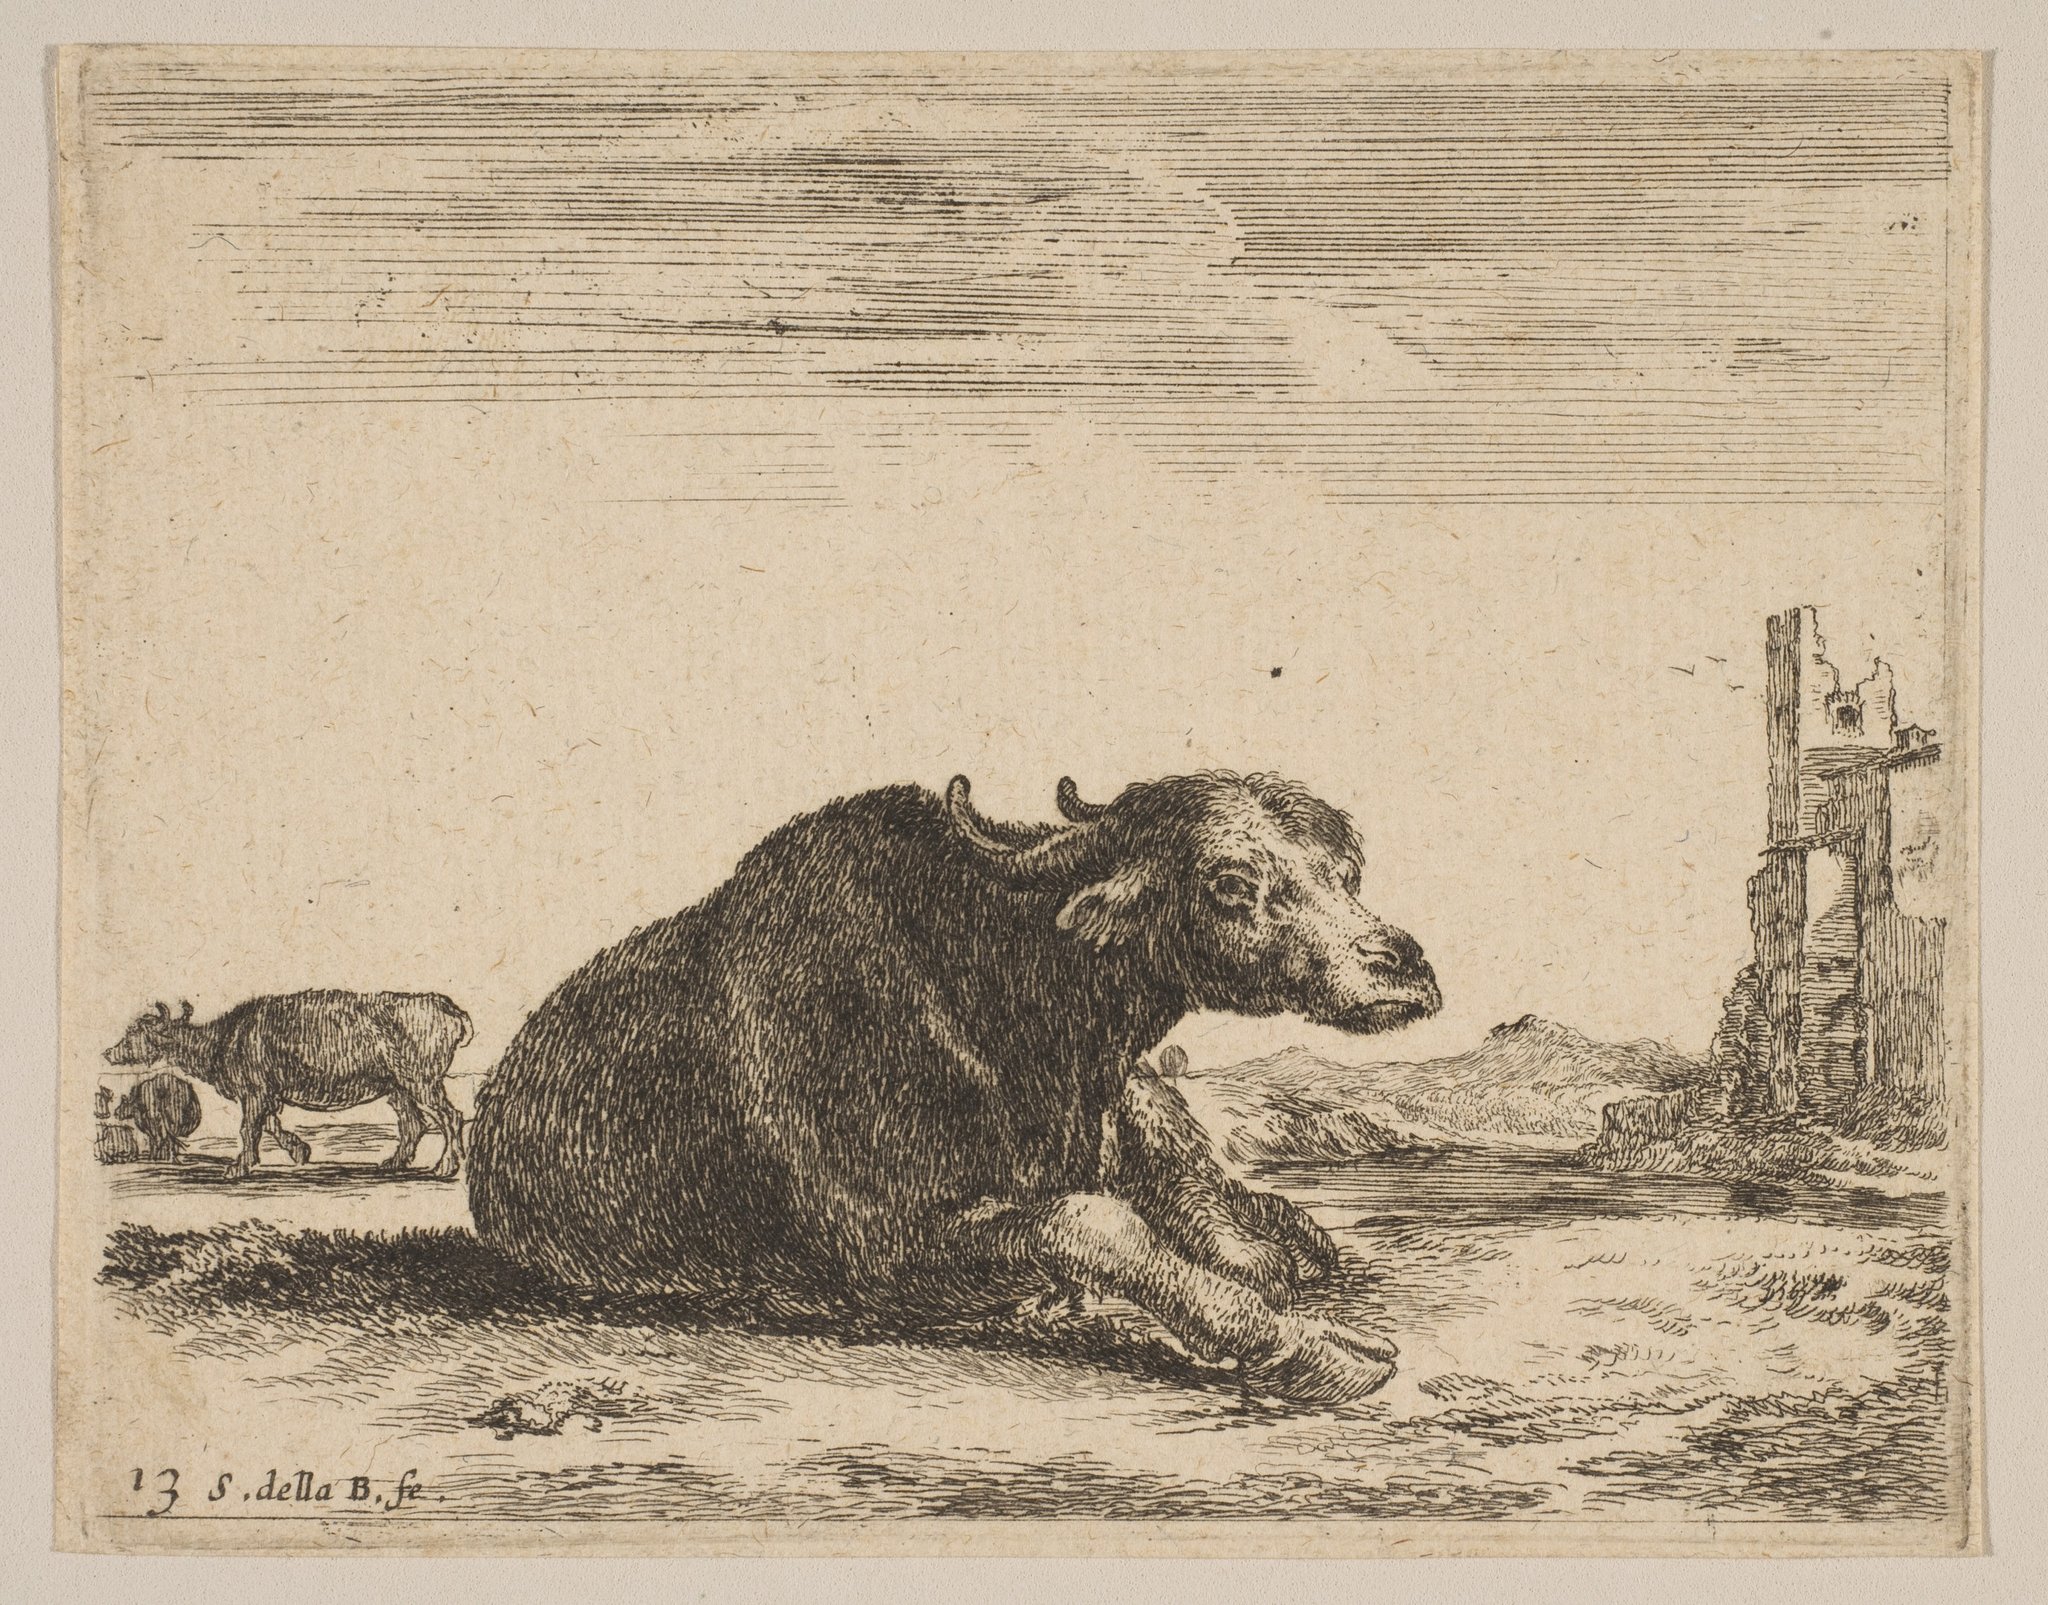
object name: print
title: Plate 13: Buffalo lying down, from "Various animals" (Diversi animali)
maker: stefano della bella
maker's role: artist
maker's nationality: italian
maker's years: 1610-1664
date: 1641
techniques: etching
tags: ruins,buffalos